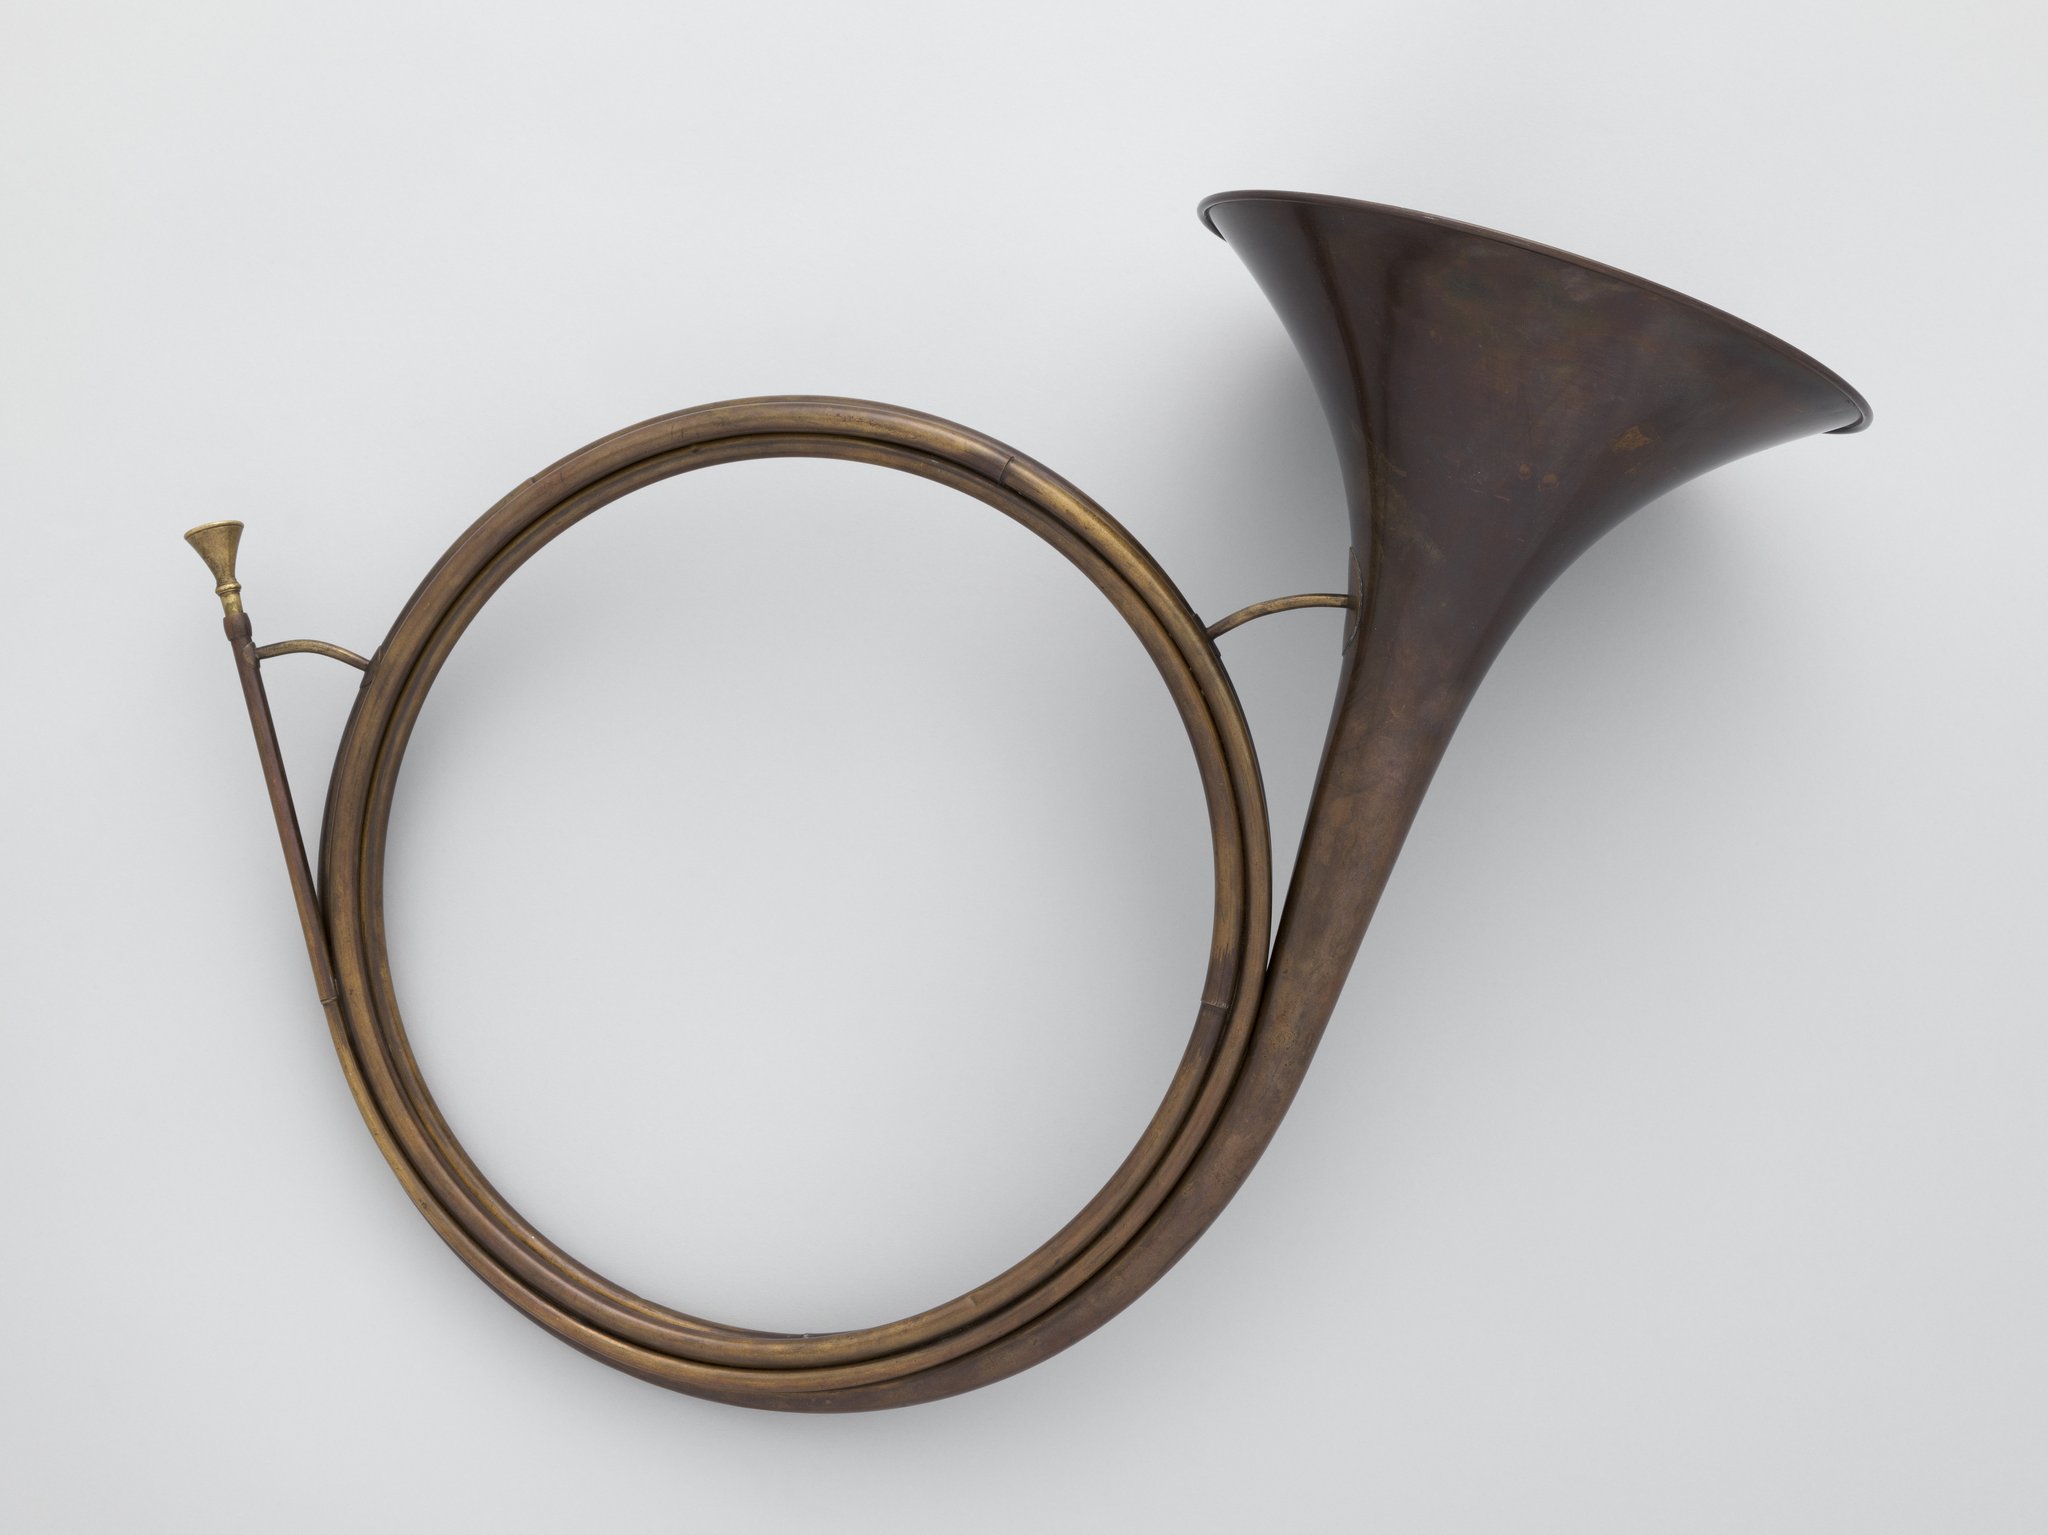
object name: hunting horn in d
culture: french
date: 1865-1880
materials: brass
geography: france